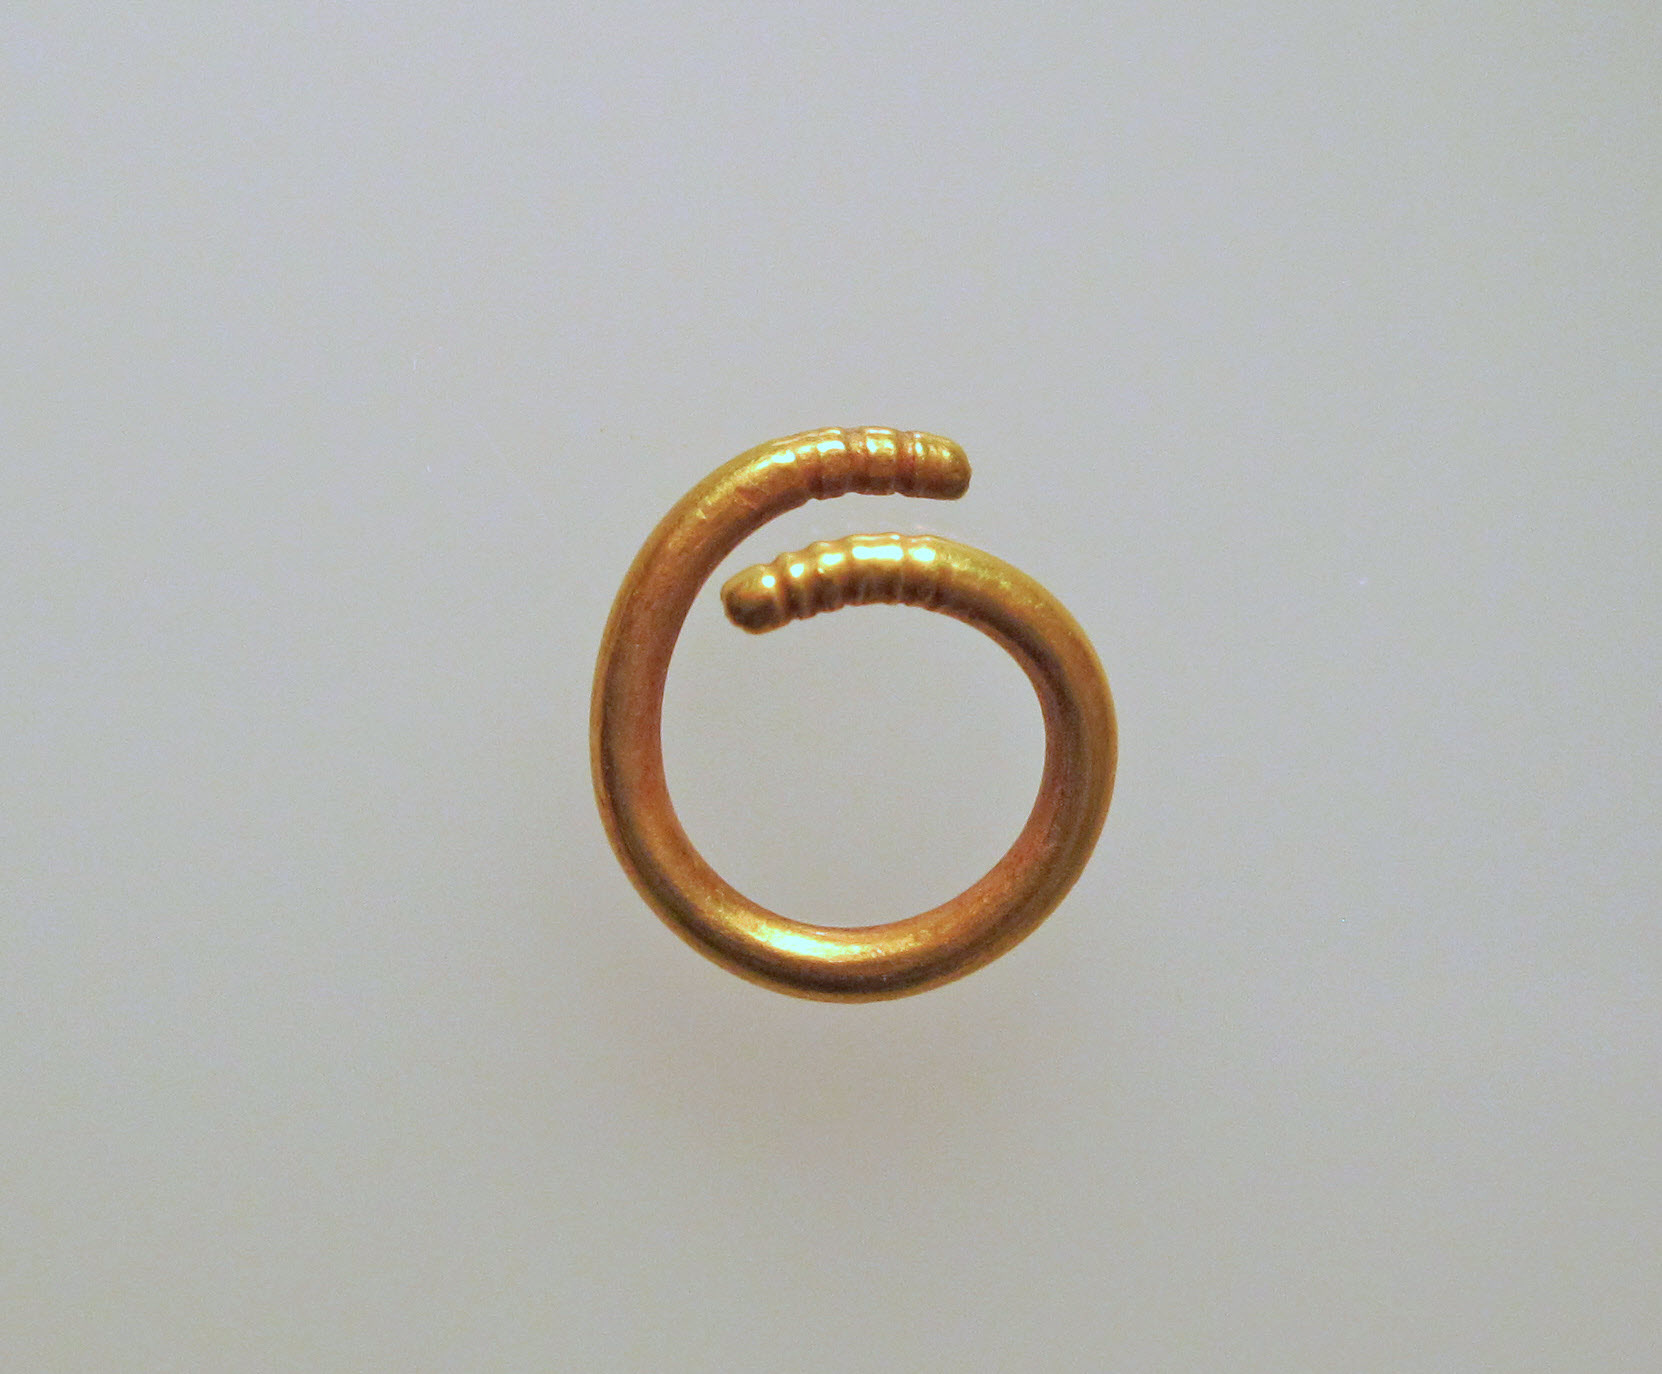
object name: spiral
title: Spirals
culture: cypriot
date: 3900 BCE-100 CE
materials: gold